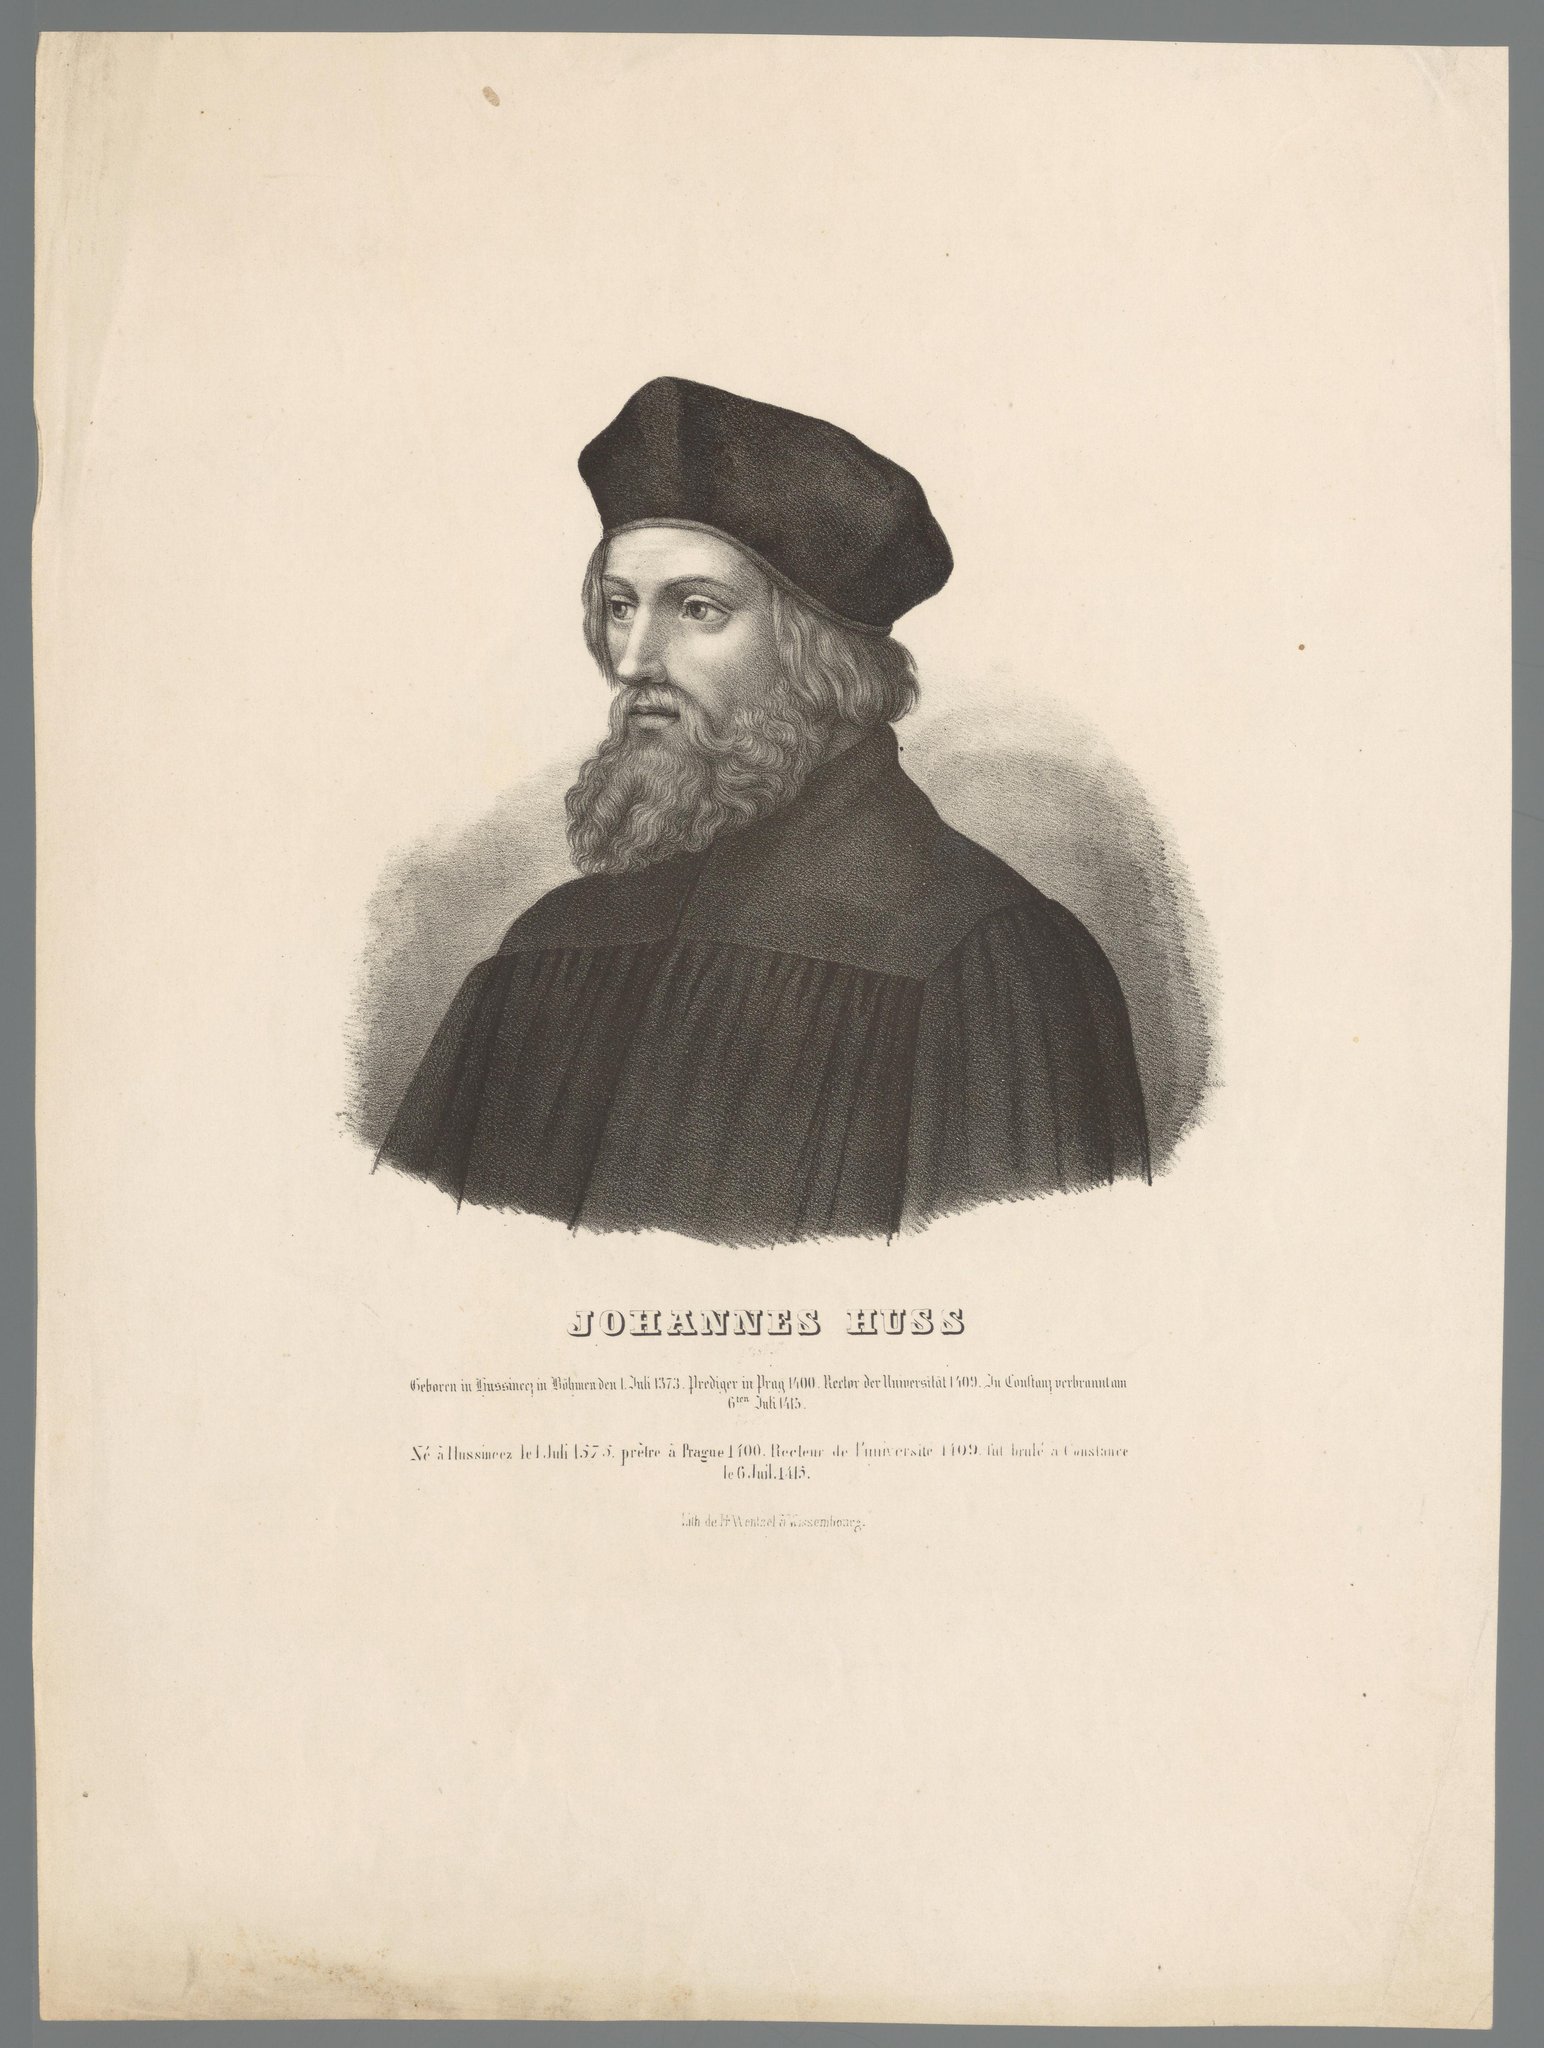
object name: print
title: Portret van Johannes Hus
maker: frédéric charles wentzel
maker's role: print maker, publisher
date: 1831-1877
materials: paper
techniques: lithograph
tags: adult man, historical persons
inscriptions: collector's mark: Lugt 2228